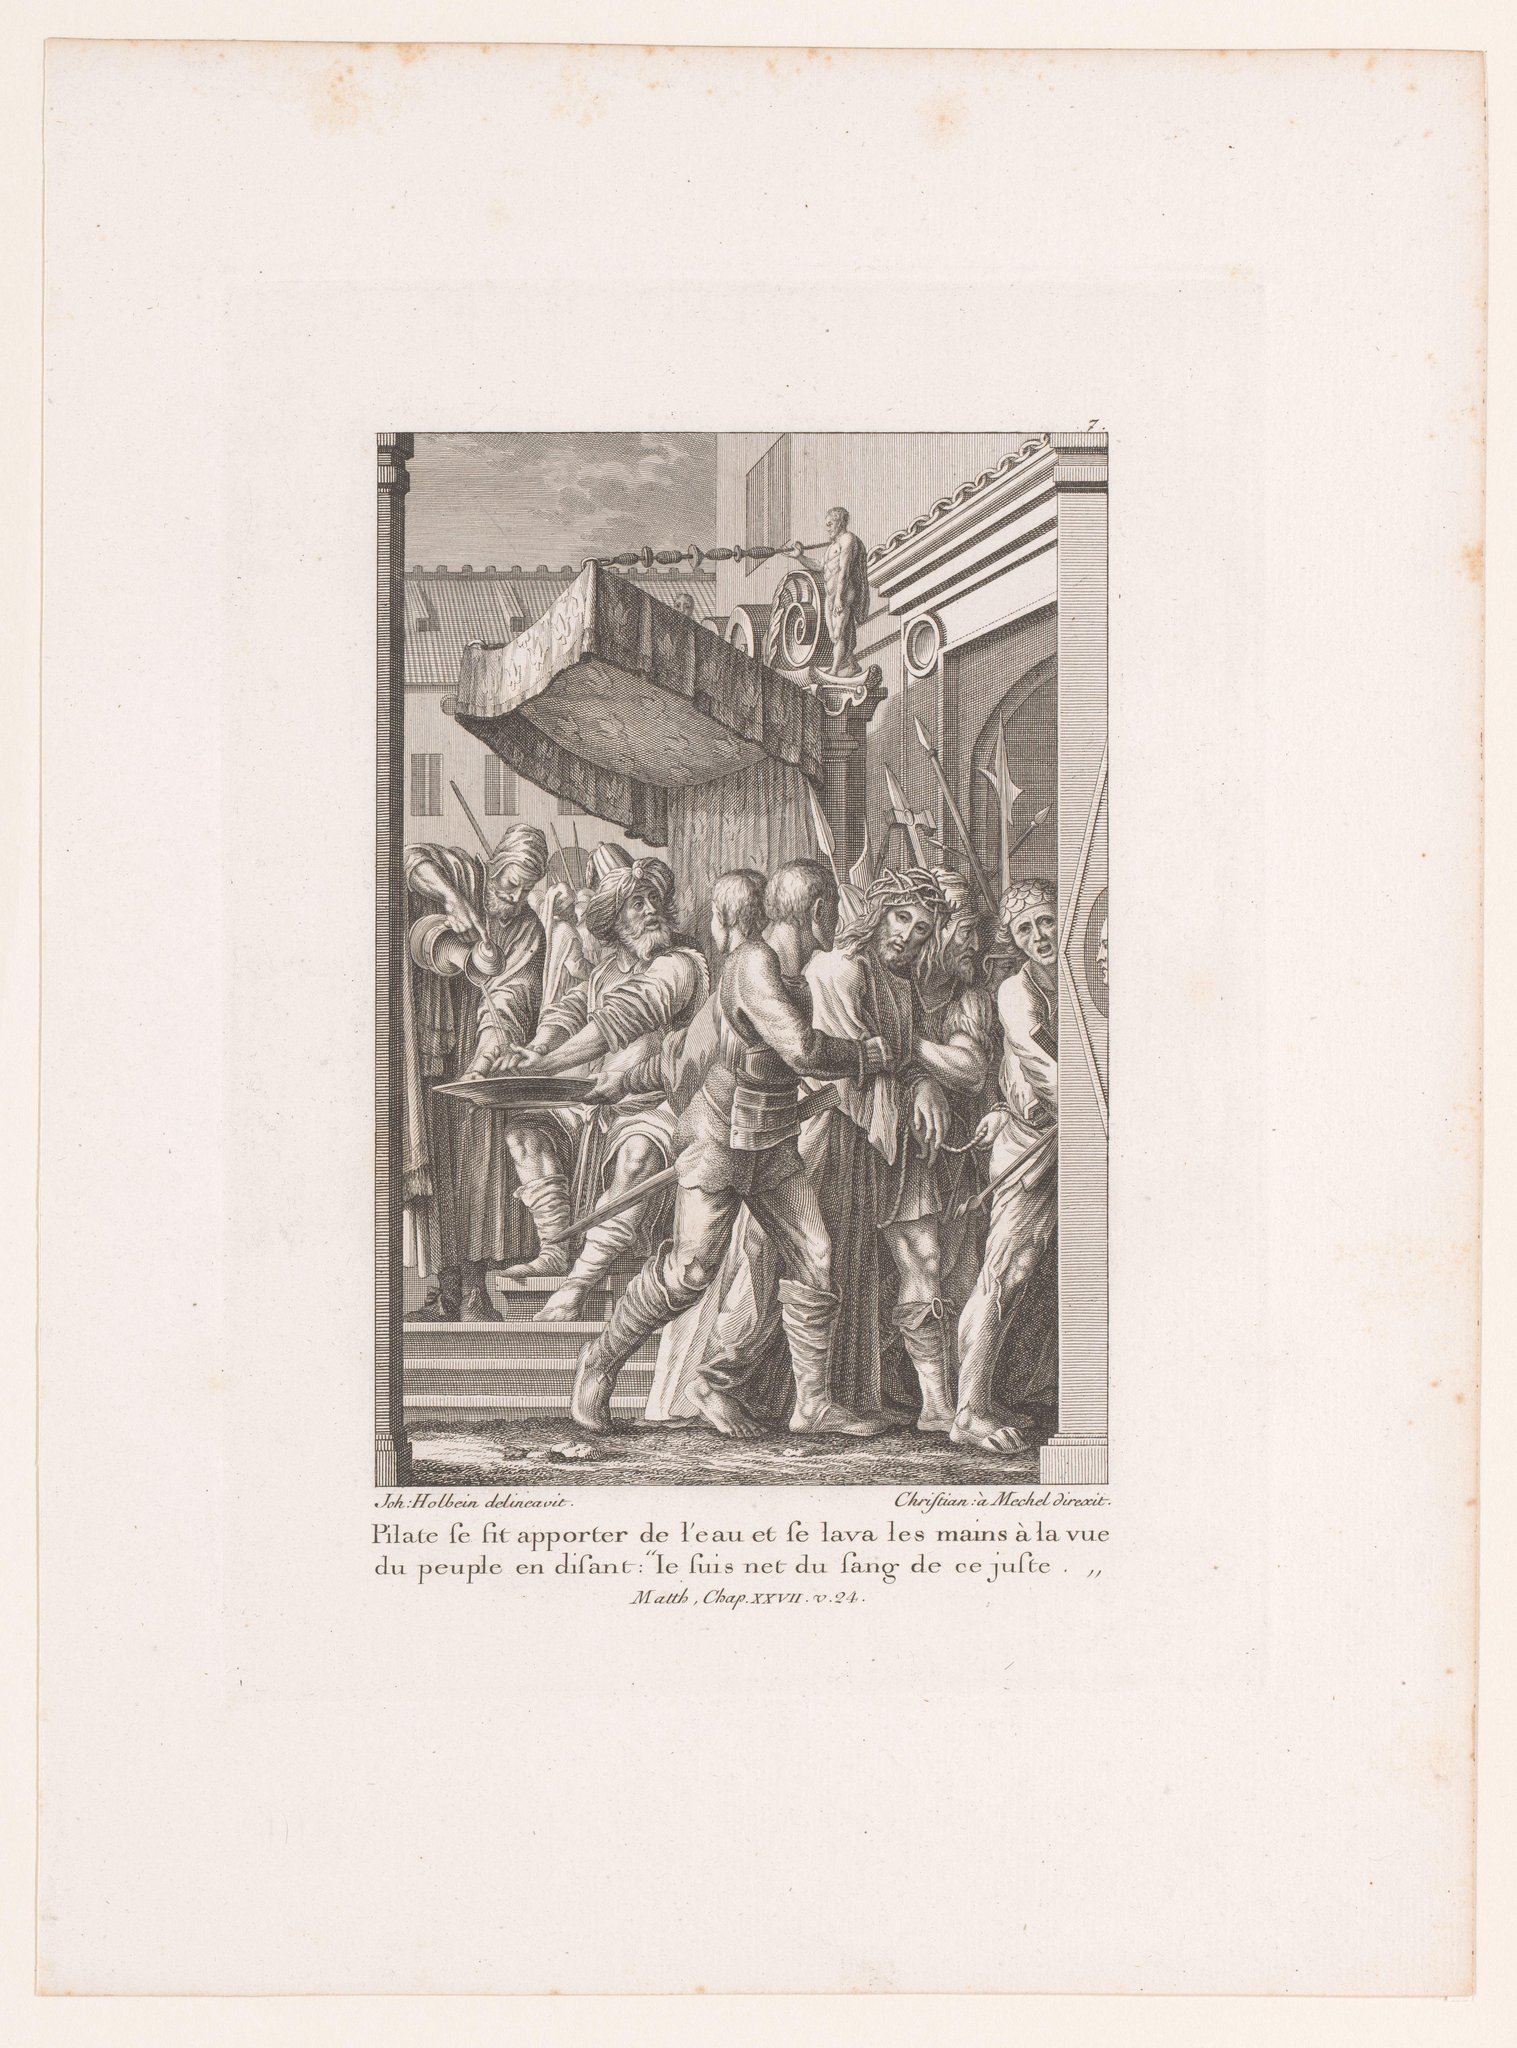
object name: print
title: Pilatus wast zijn handen in onschuld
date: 1784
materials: paper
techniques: etching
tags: pilate washing his hands (in innocence)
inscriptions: collector's mark: Lugt 2228, collector's mark: Lugt 4404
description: Pilatus zit op zijn troon onder een baldakijn en wast zijn handen in een basin dat hem wordt voorgehouden. Christus wordt weggeleid.